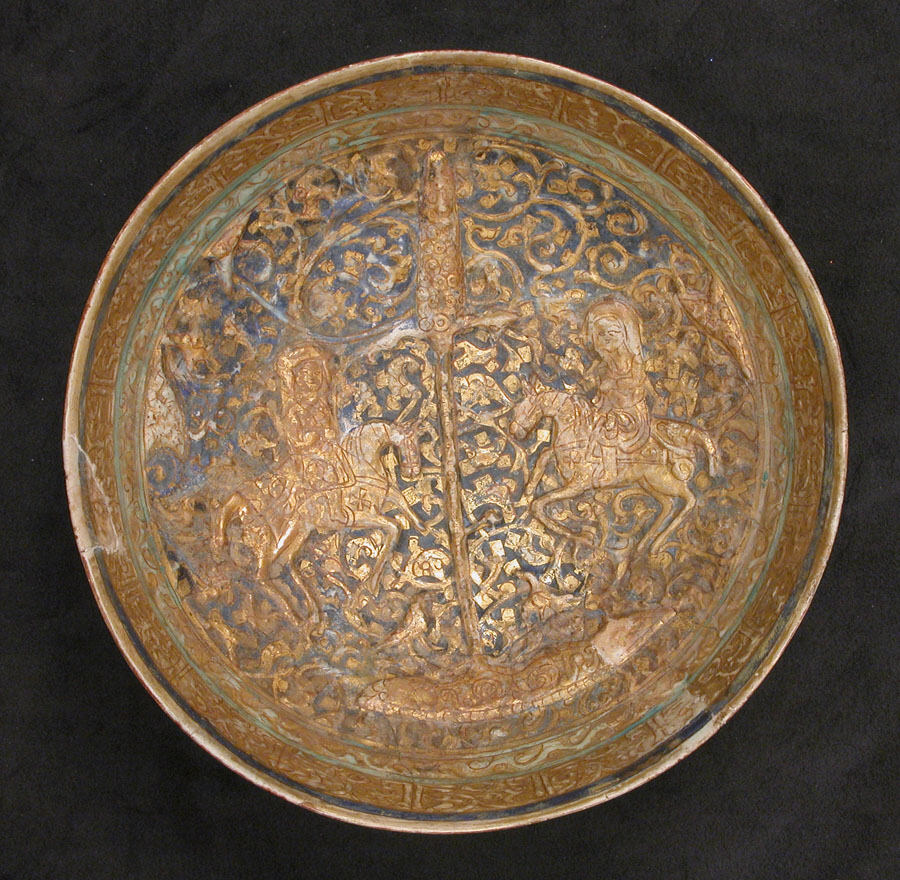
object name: bowl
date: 1101-1300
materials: stonepaste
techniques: overglaze, painting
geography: iran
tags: horses